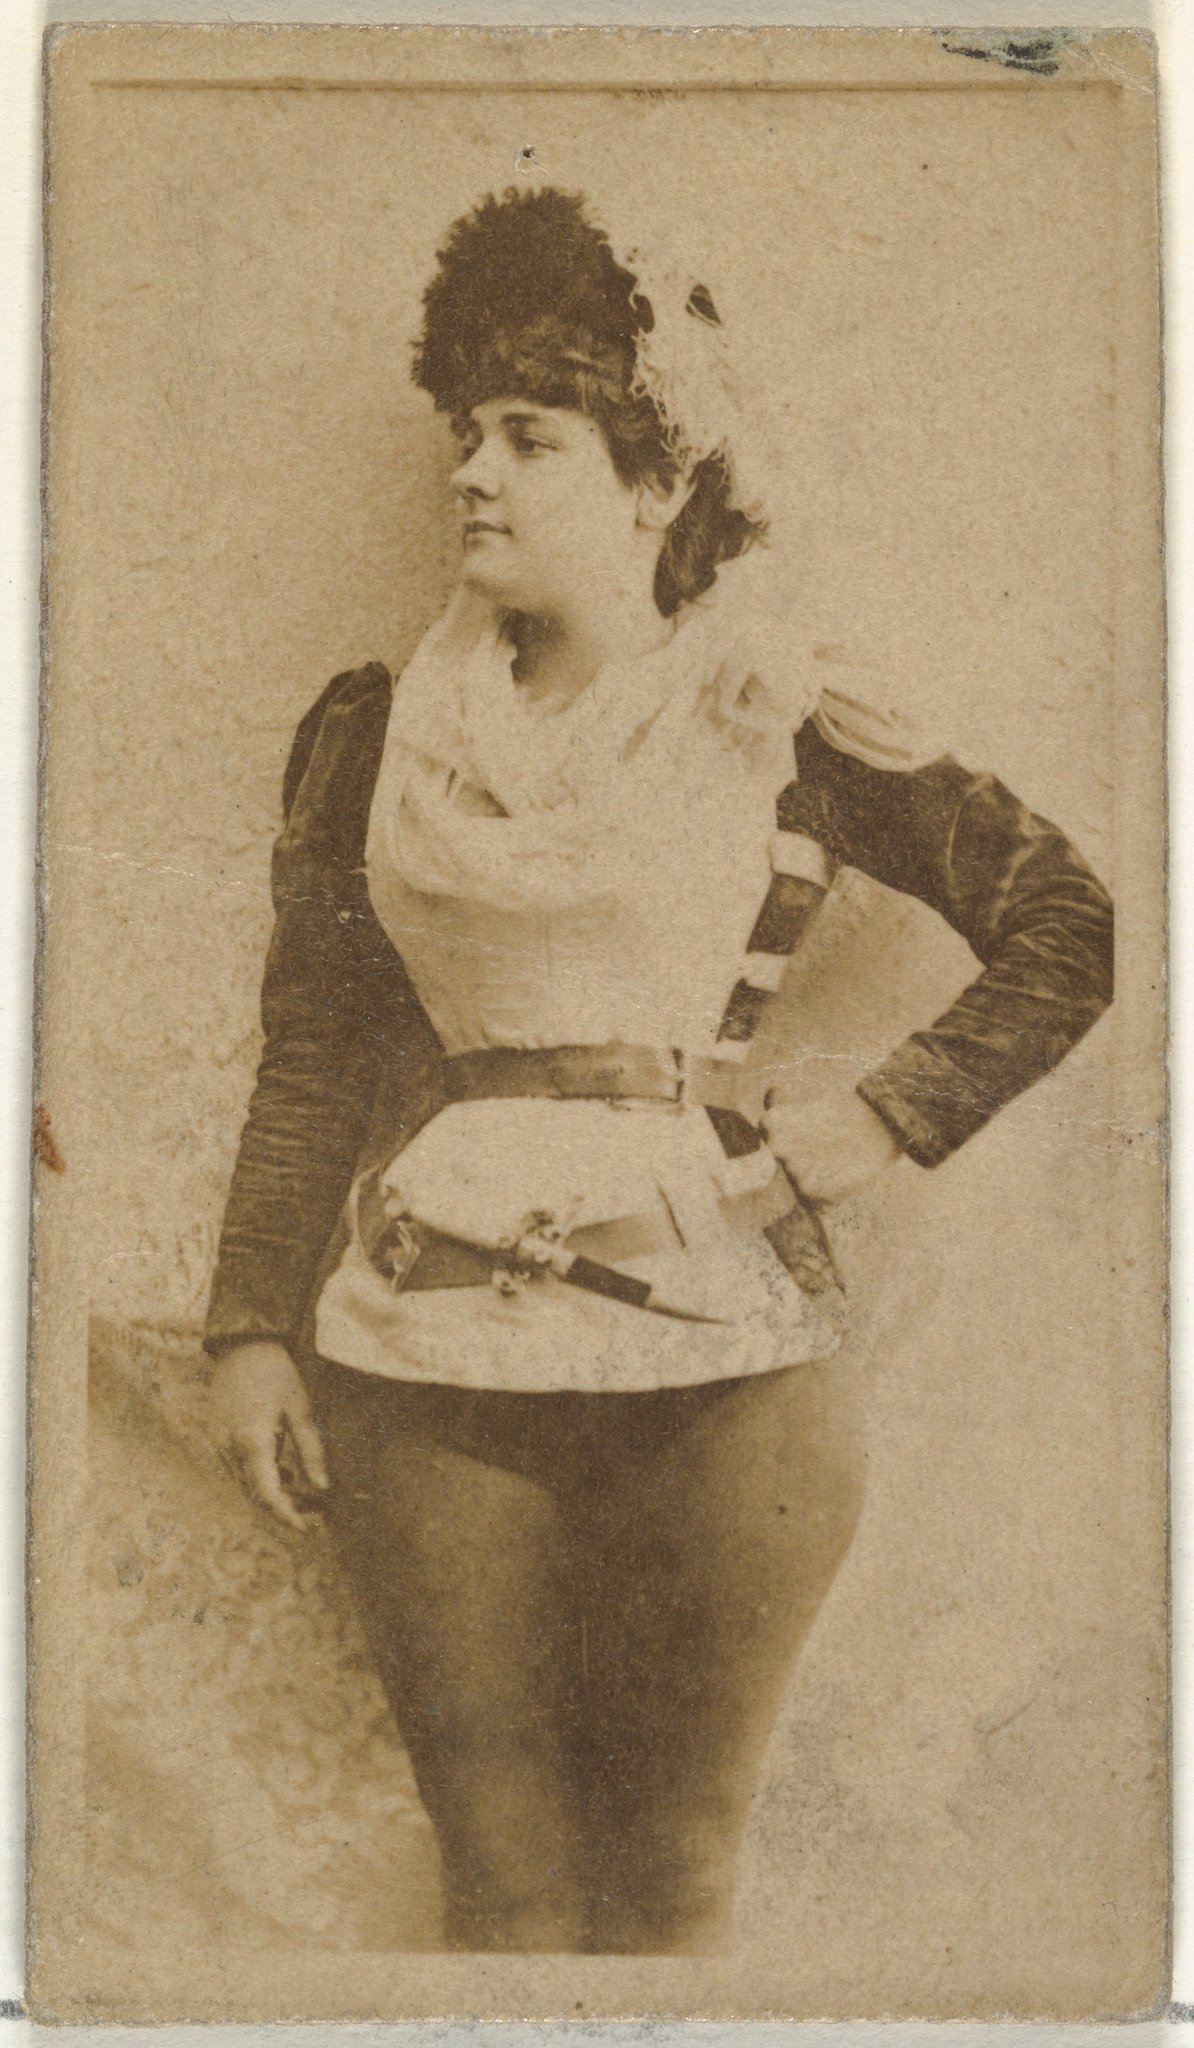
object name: photograph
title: [Actress standing with hand on hip], from the Actors and Actresses series (N145-8) issued by Duke Sons & Co. to promote Duke Cigarettes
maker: w. duke, sons & co.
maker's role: publisher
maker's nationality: american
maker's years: 1870-1920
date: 1891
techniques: albumen silver print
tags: portraits,women,actresses